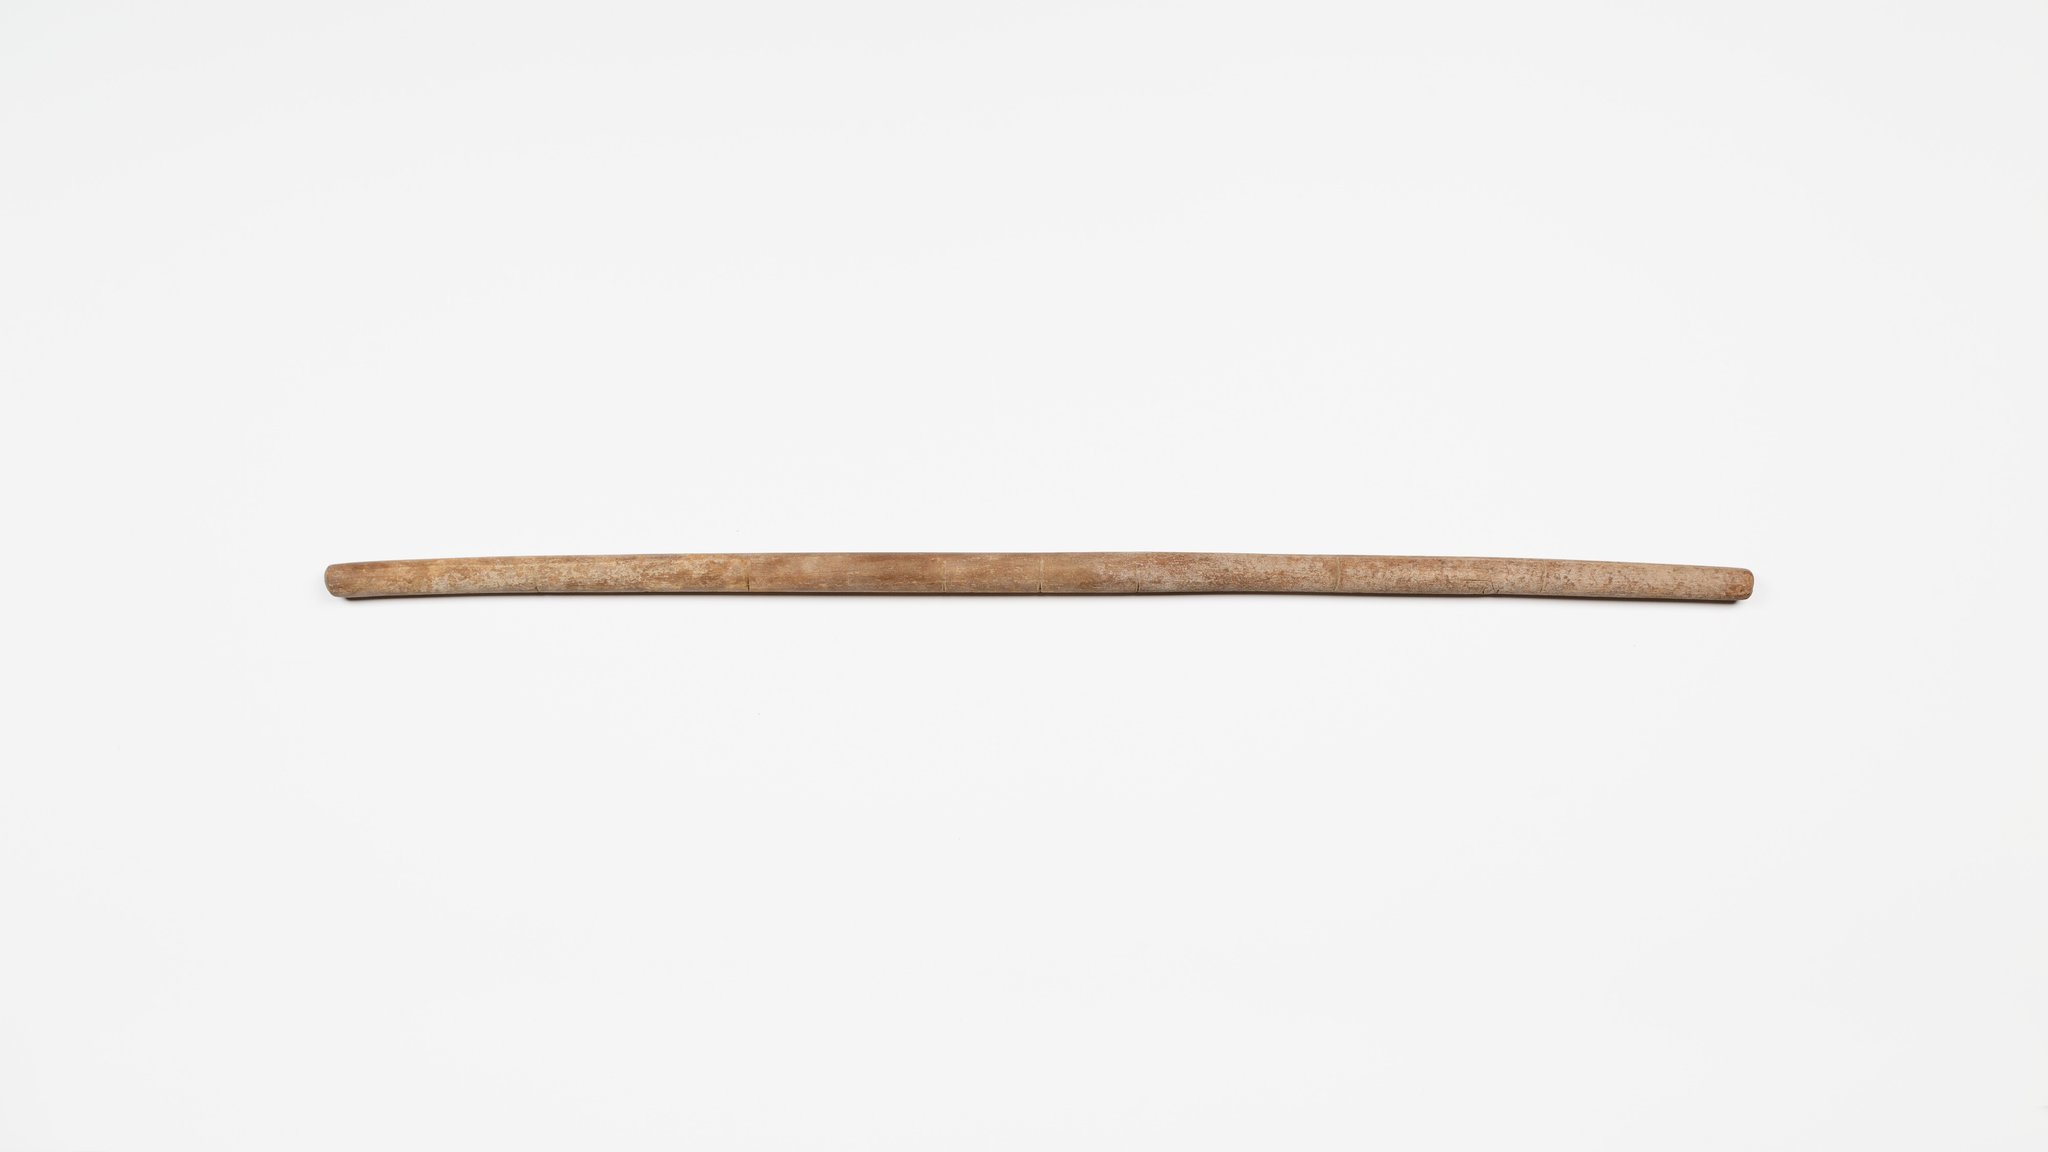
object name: cubit rod, measuring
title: Cubit measuring rod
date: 1981-1640 BCE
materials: wood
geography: egypt